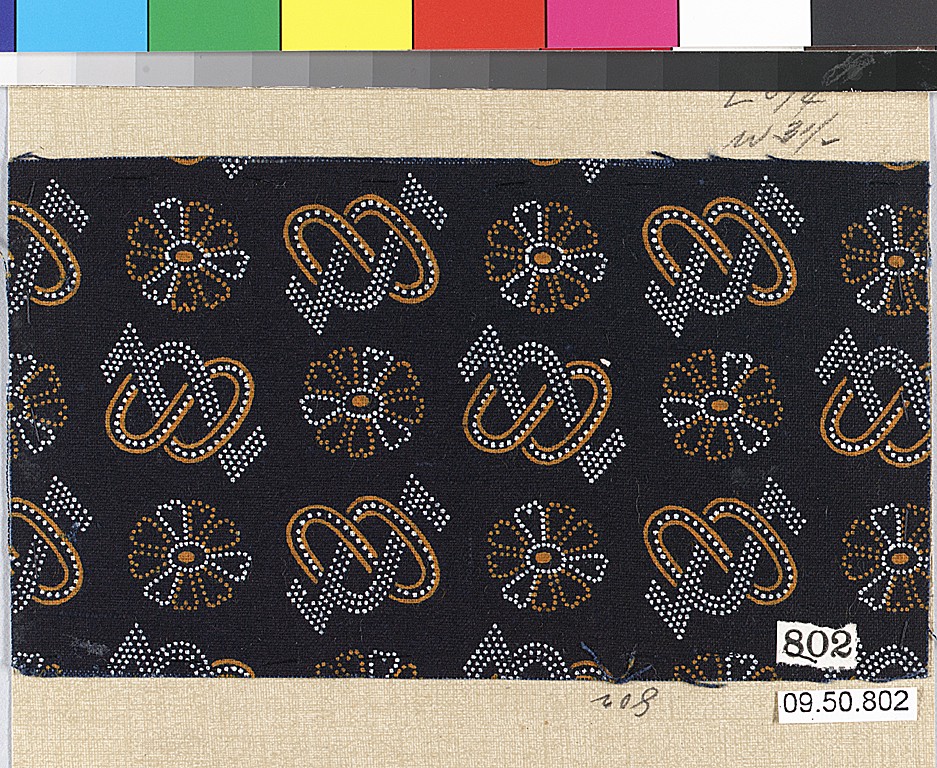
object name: piece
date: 1801-1900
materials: cotton